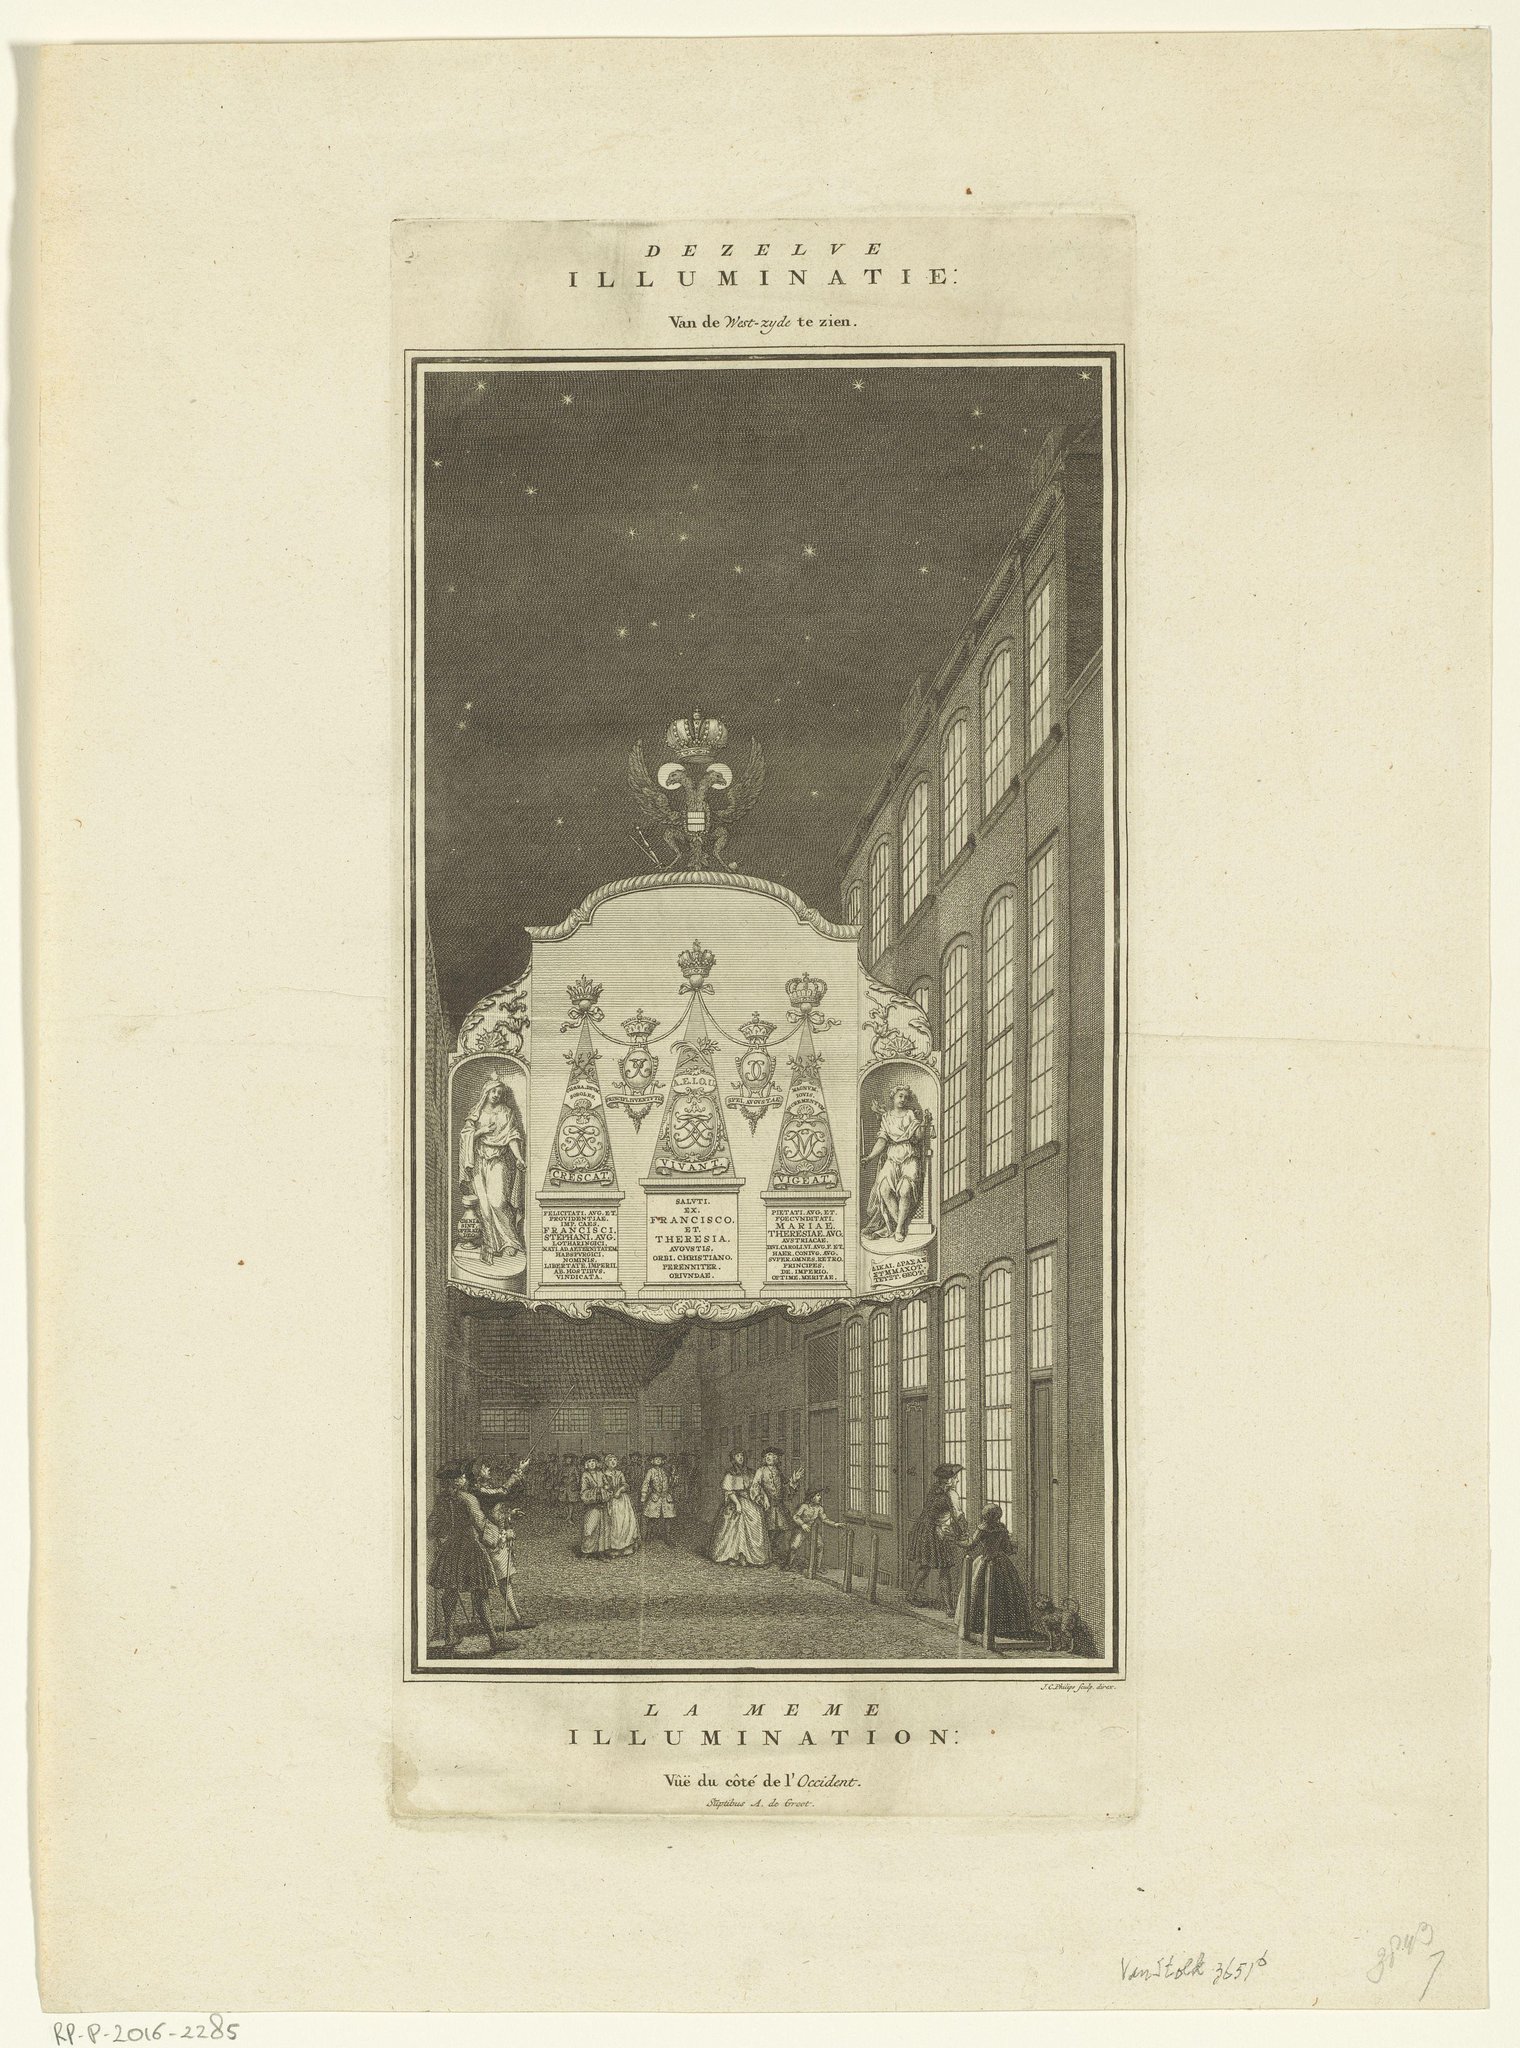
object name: print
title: Dezelve illuminatie: van de west-zyde te zien / La meme illumination: vûë du côté de l'occident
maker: jan caspar philips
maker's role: draughtsman, print maker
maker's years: 1700-1775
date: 1745-1747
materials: paper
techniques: engraving, etching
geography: northern netherlands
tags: anthoni de groot, frans i stefan (duits keizer), public festivities (+ decorated staff, portable structure ~ festive activities), coronation of a ruler, bonfire, fire-works (+ illumination, fire-works ~ festive activities), the hague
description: Illuminatie ter gelegenheid van de kroning van Frans I Stefan tot keizer op 4-6 oktober 1745 opgericht voor het huis van de uitgever Anthoni de Groot te Den Haag, gezien vanuit de westzijde. Een groot verlicht bord hangend over de straat met obelisken en allegorische figuren.